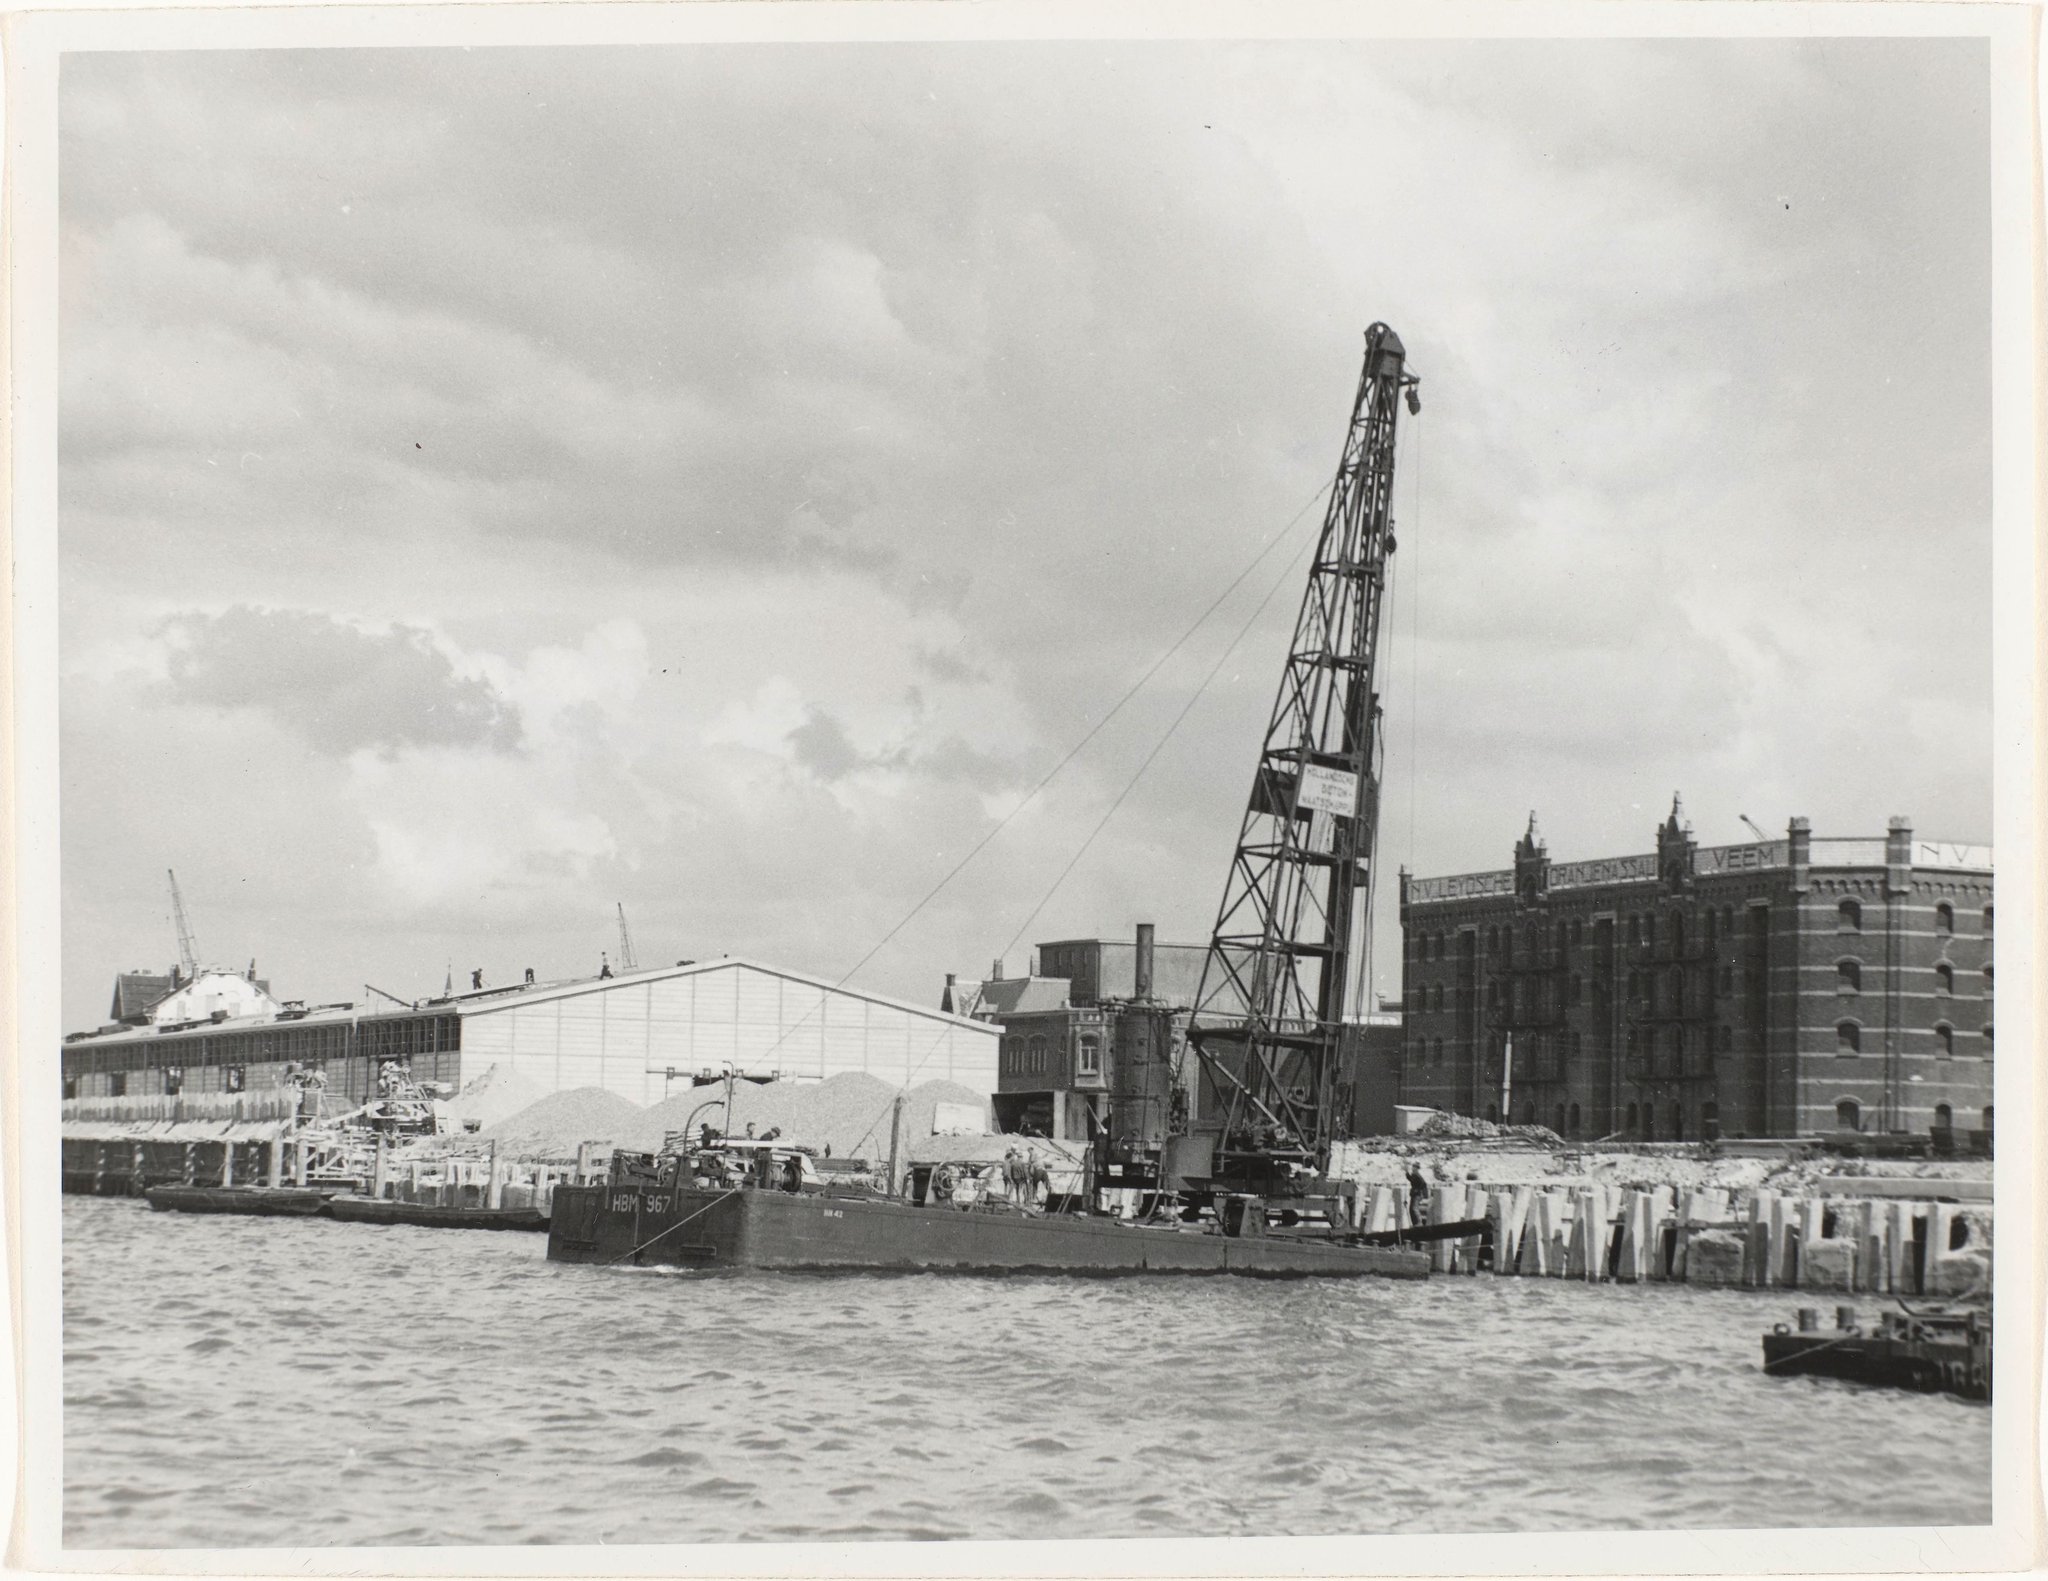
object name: documentary photograph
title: Hulp uit USA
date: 1946-1947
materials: photographic support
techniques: photography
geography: rotterdam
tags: rotterdam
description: Staal uit de USA voor de wederopbouw van de haven van Rotterdam.